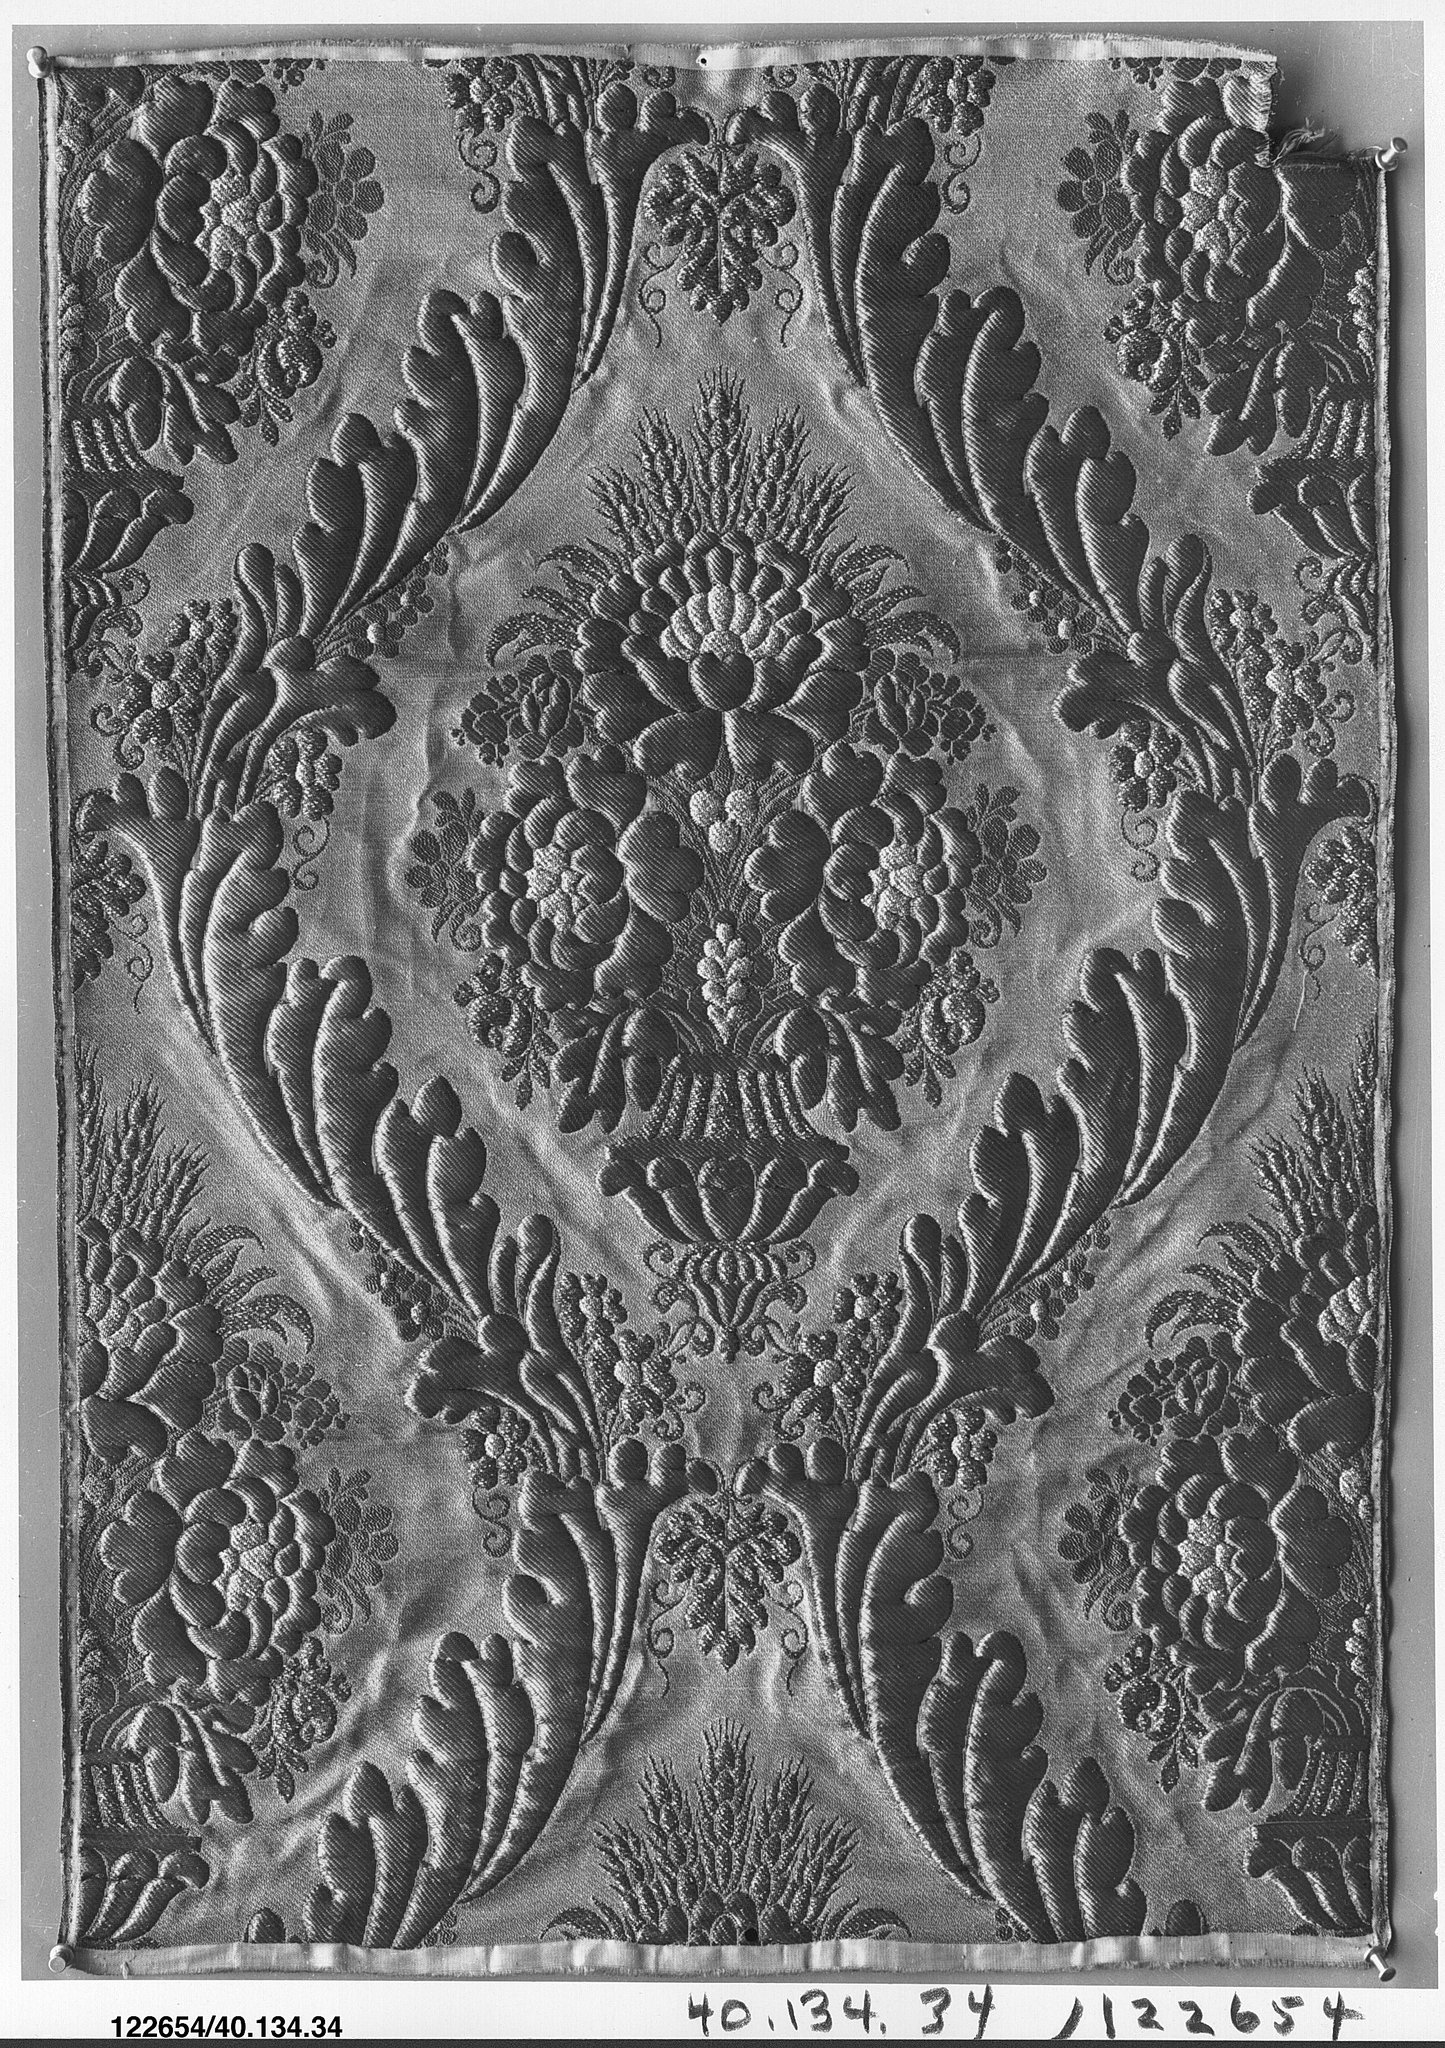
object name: piece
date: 1701-1900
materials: metal thread, silk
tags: flowers,leaves